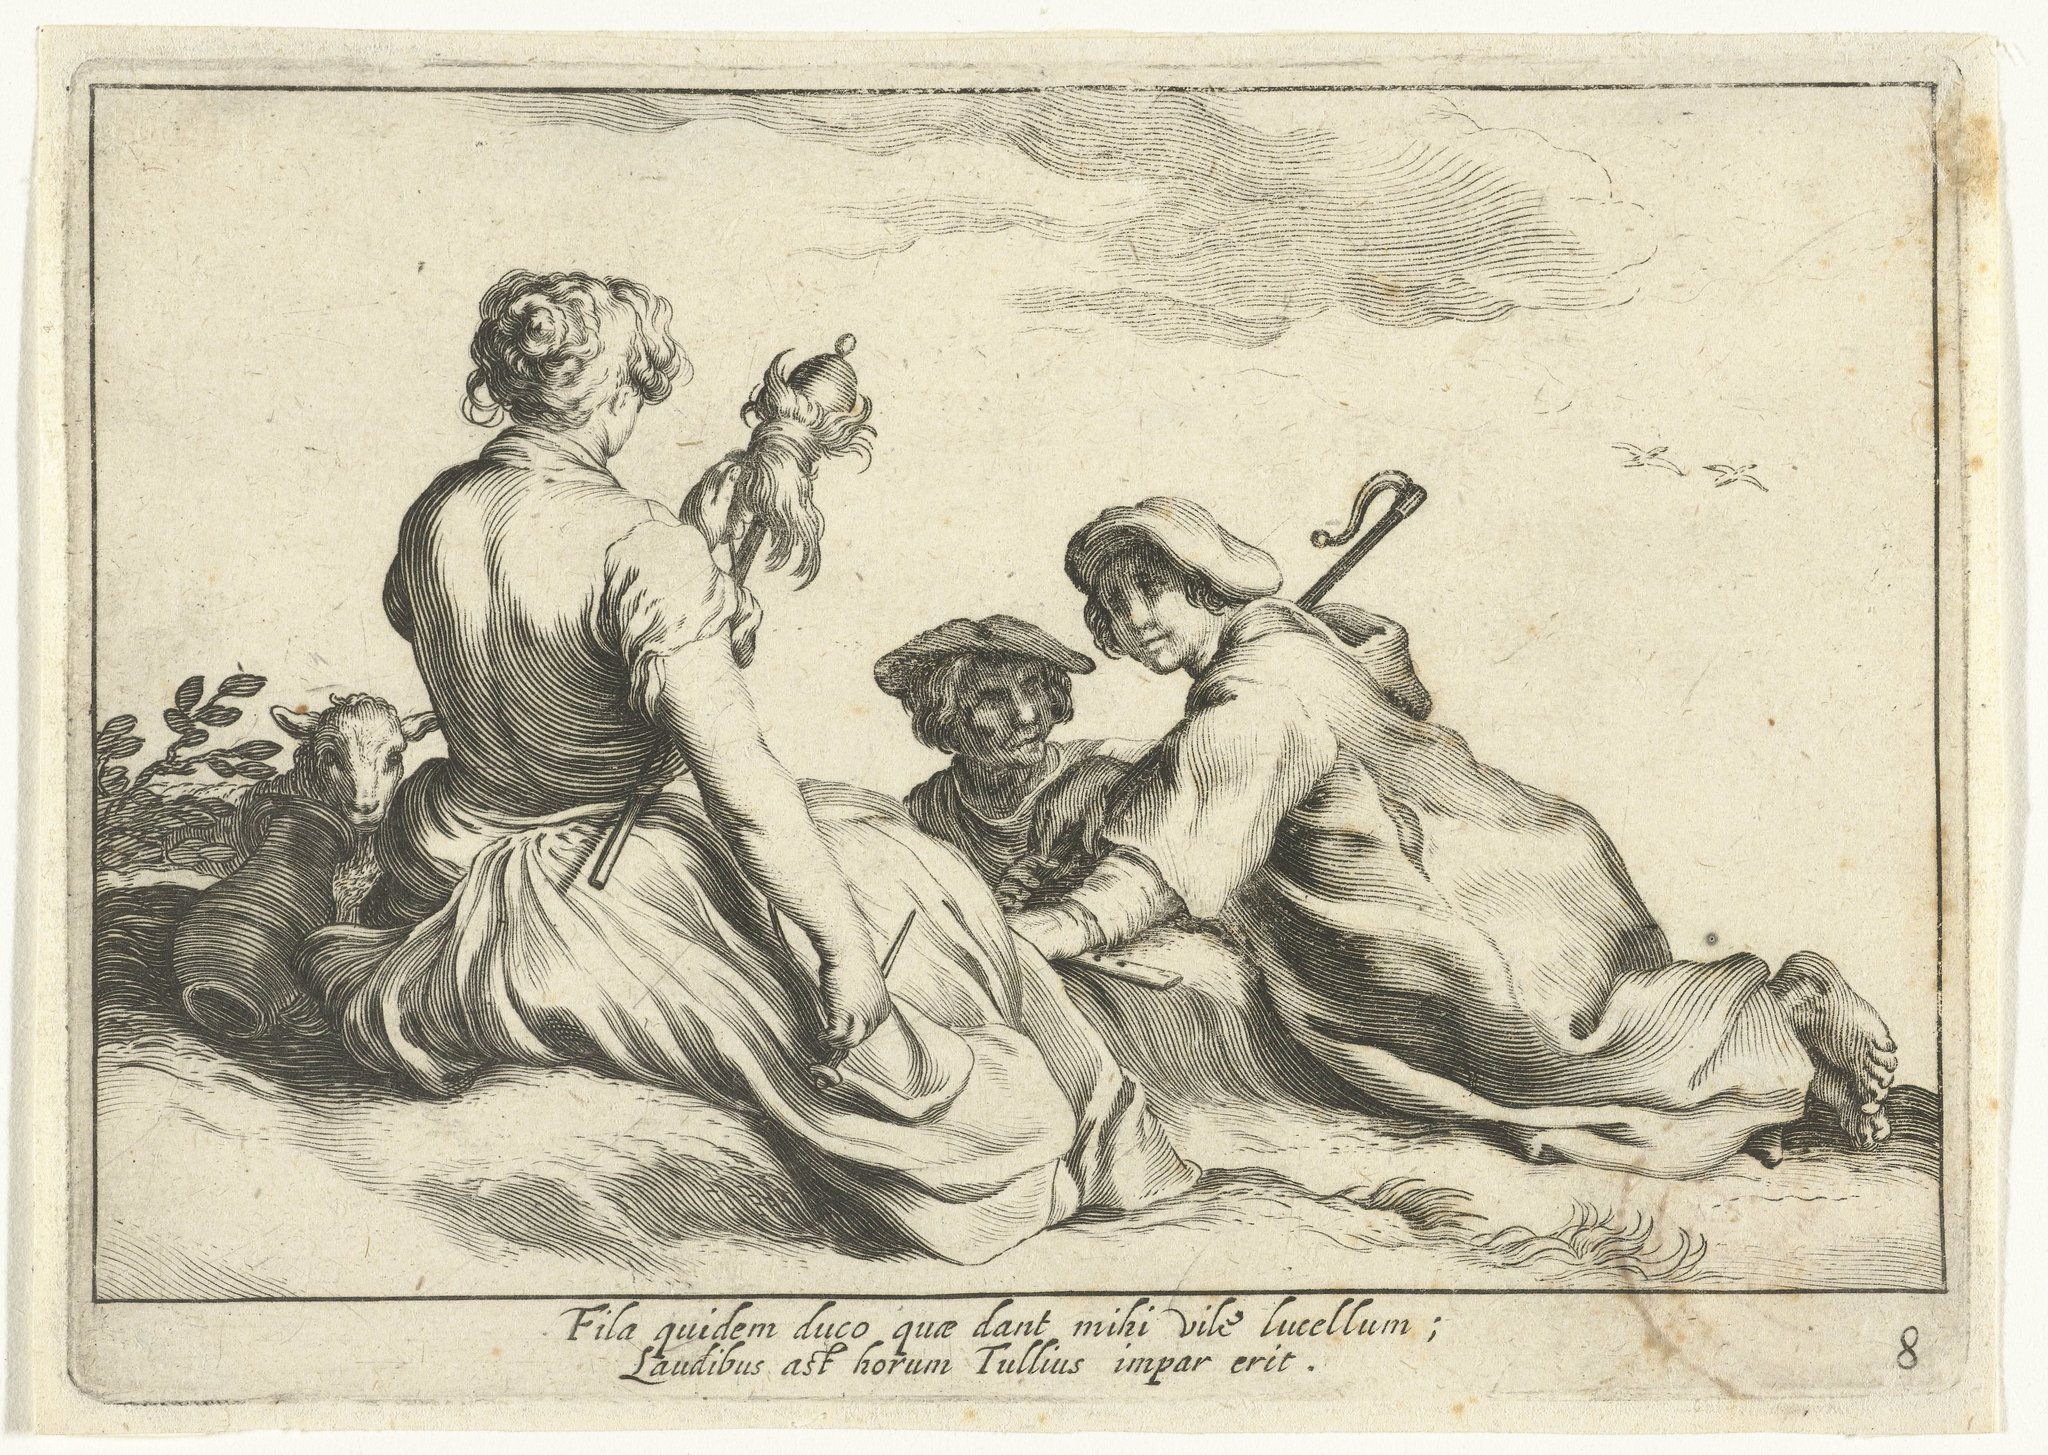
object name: print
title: Otia delectant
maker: cornelis bloemaert (ii)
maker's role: draughtsman, print maker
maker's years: 1603-1692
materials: paper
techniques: engraving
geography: utrecht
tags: herding, herdsman, herdswoman, shepherd, shepherdess, cowherd, etc., pastorals, arcadian scenes, spinning (manufacture of yarn)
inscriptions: collector's mark: Lugt 240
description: Een oudere en jonge man zitten met een vrouw op het gras. De vrouw houdt een stok omwonden met garen in haar hand. Met tweeregelig Latijns onderschrift.